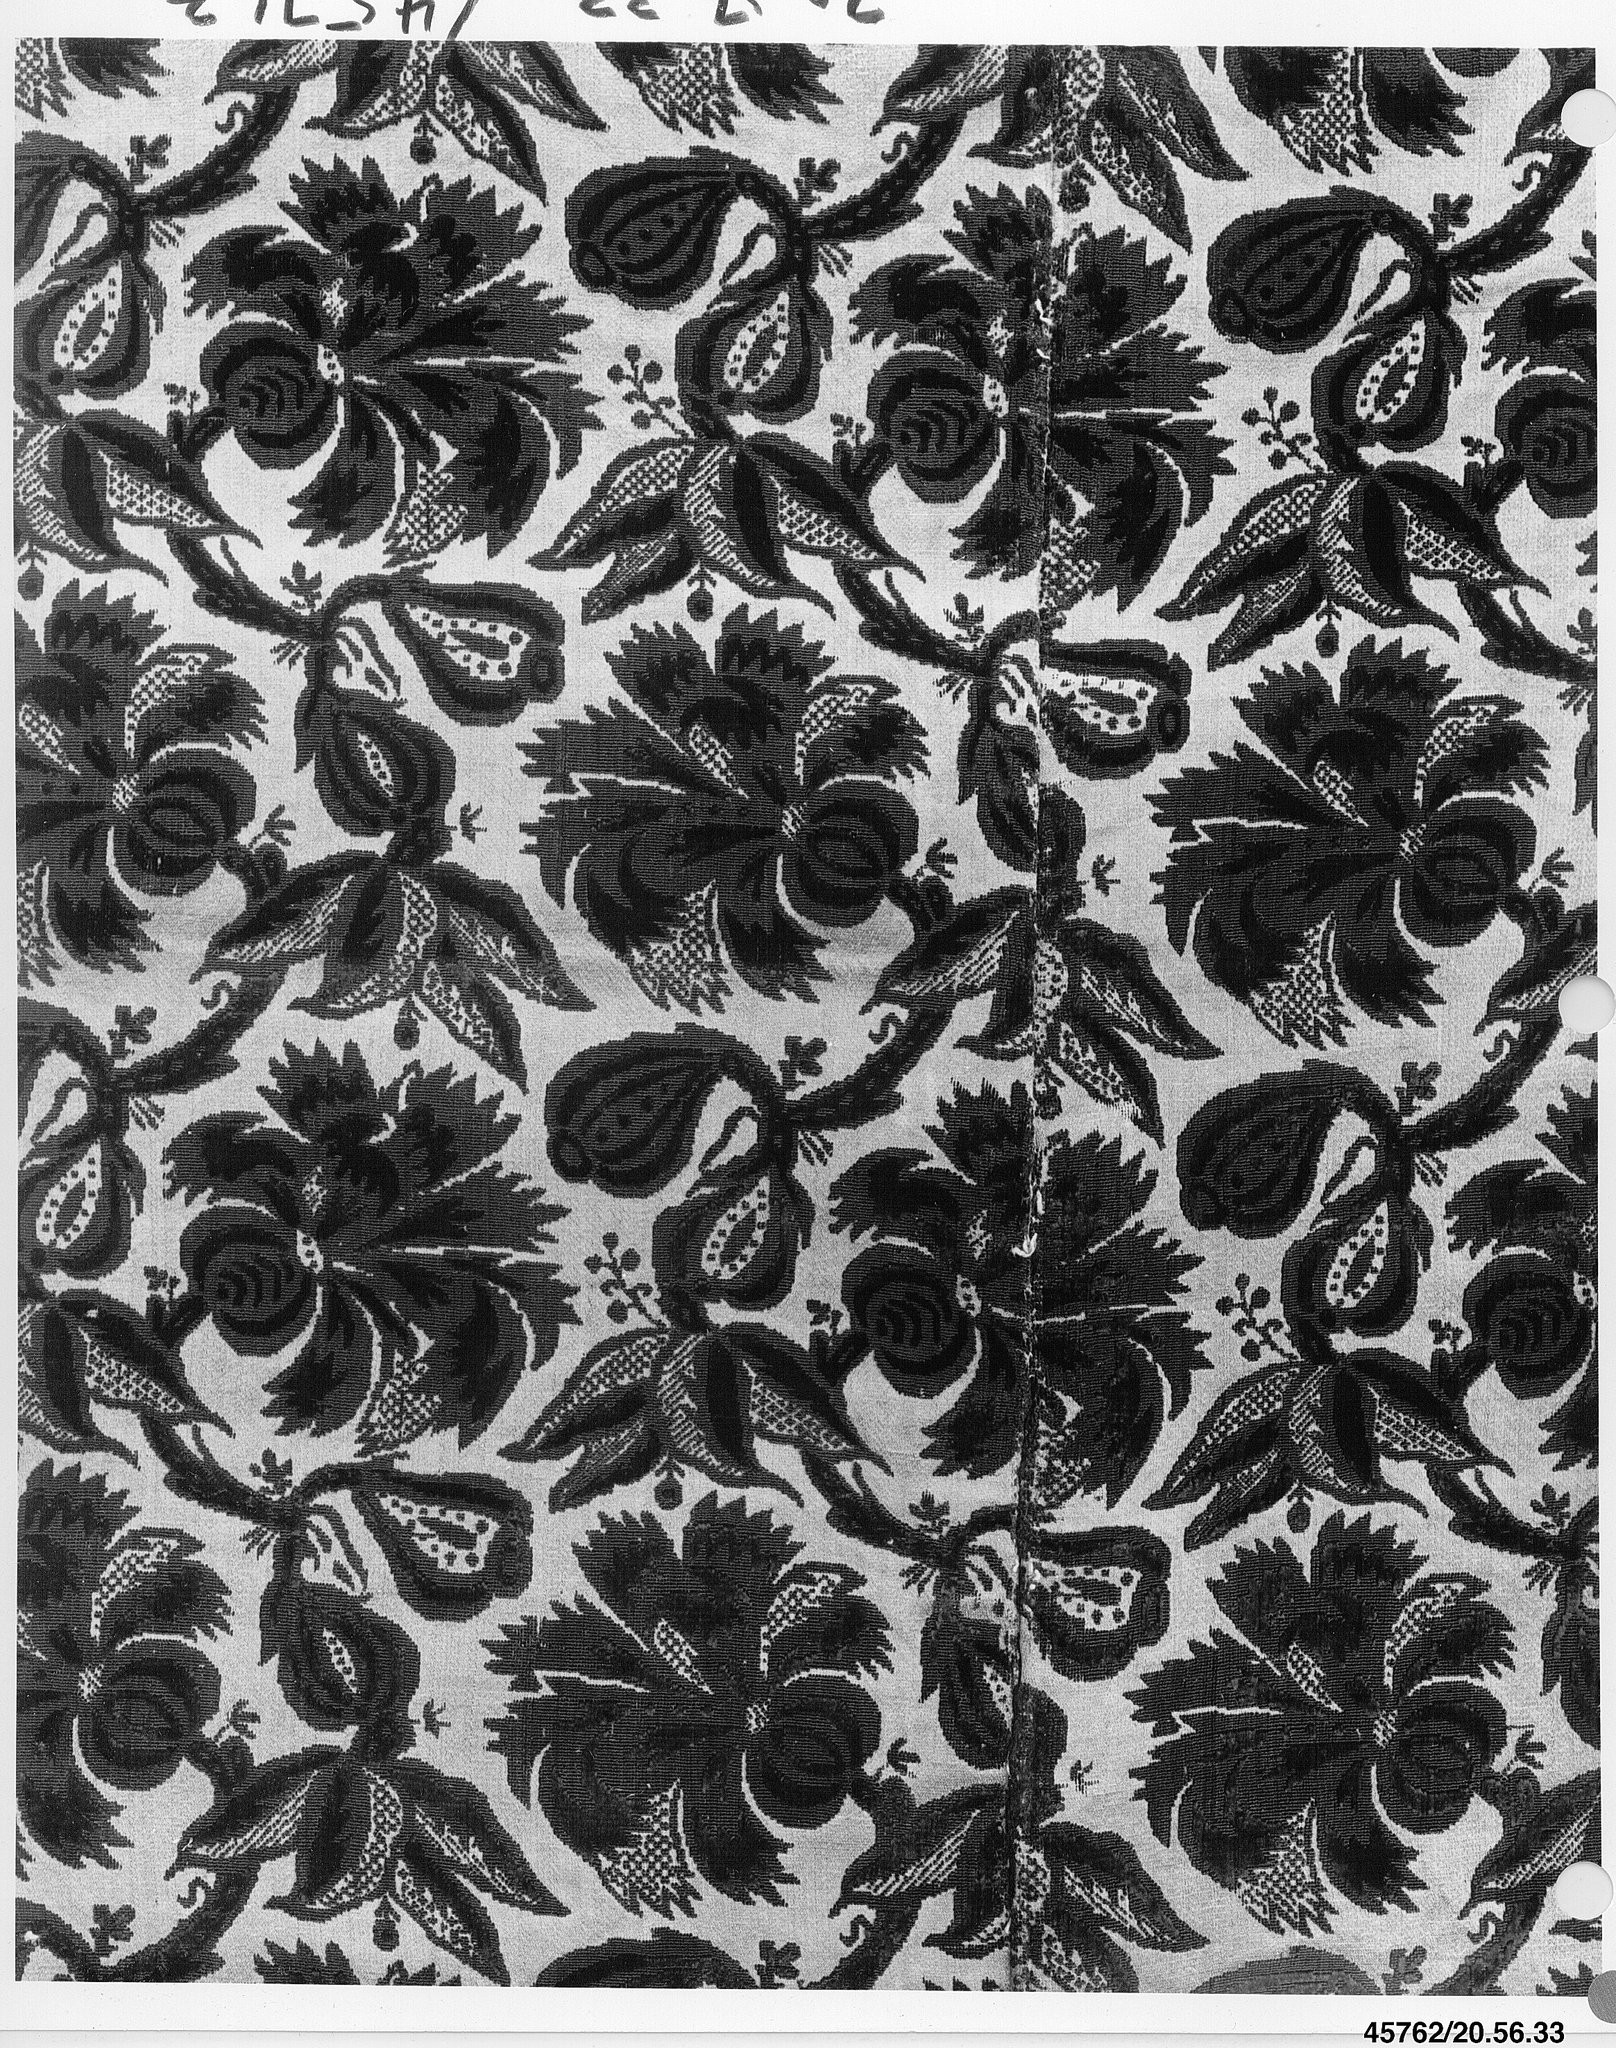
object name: piece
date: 1601-1700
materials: silk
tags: flowers,leaves